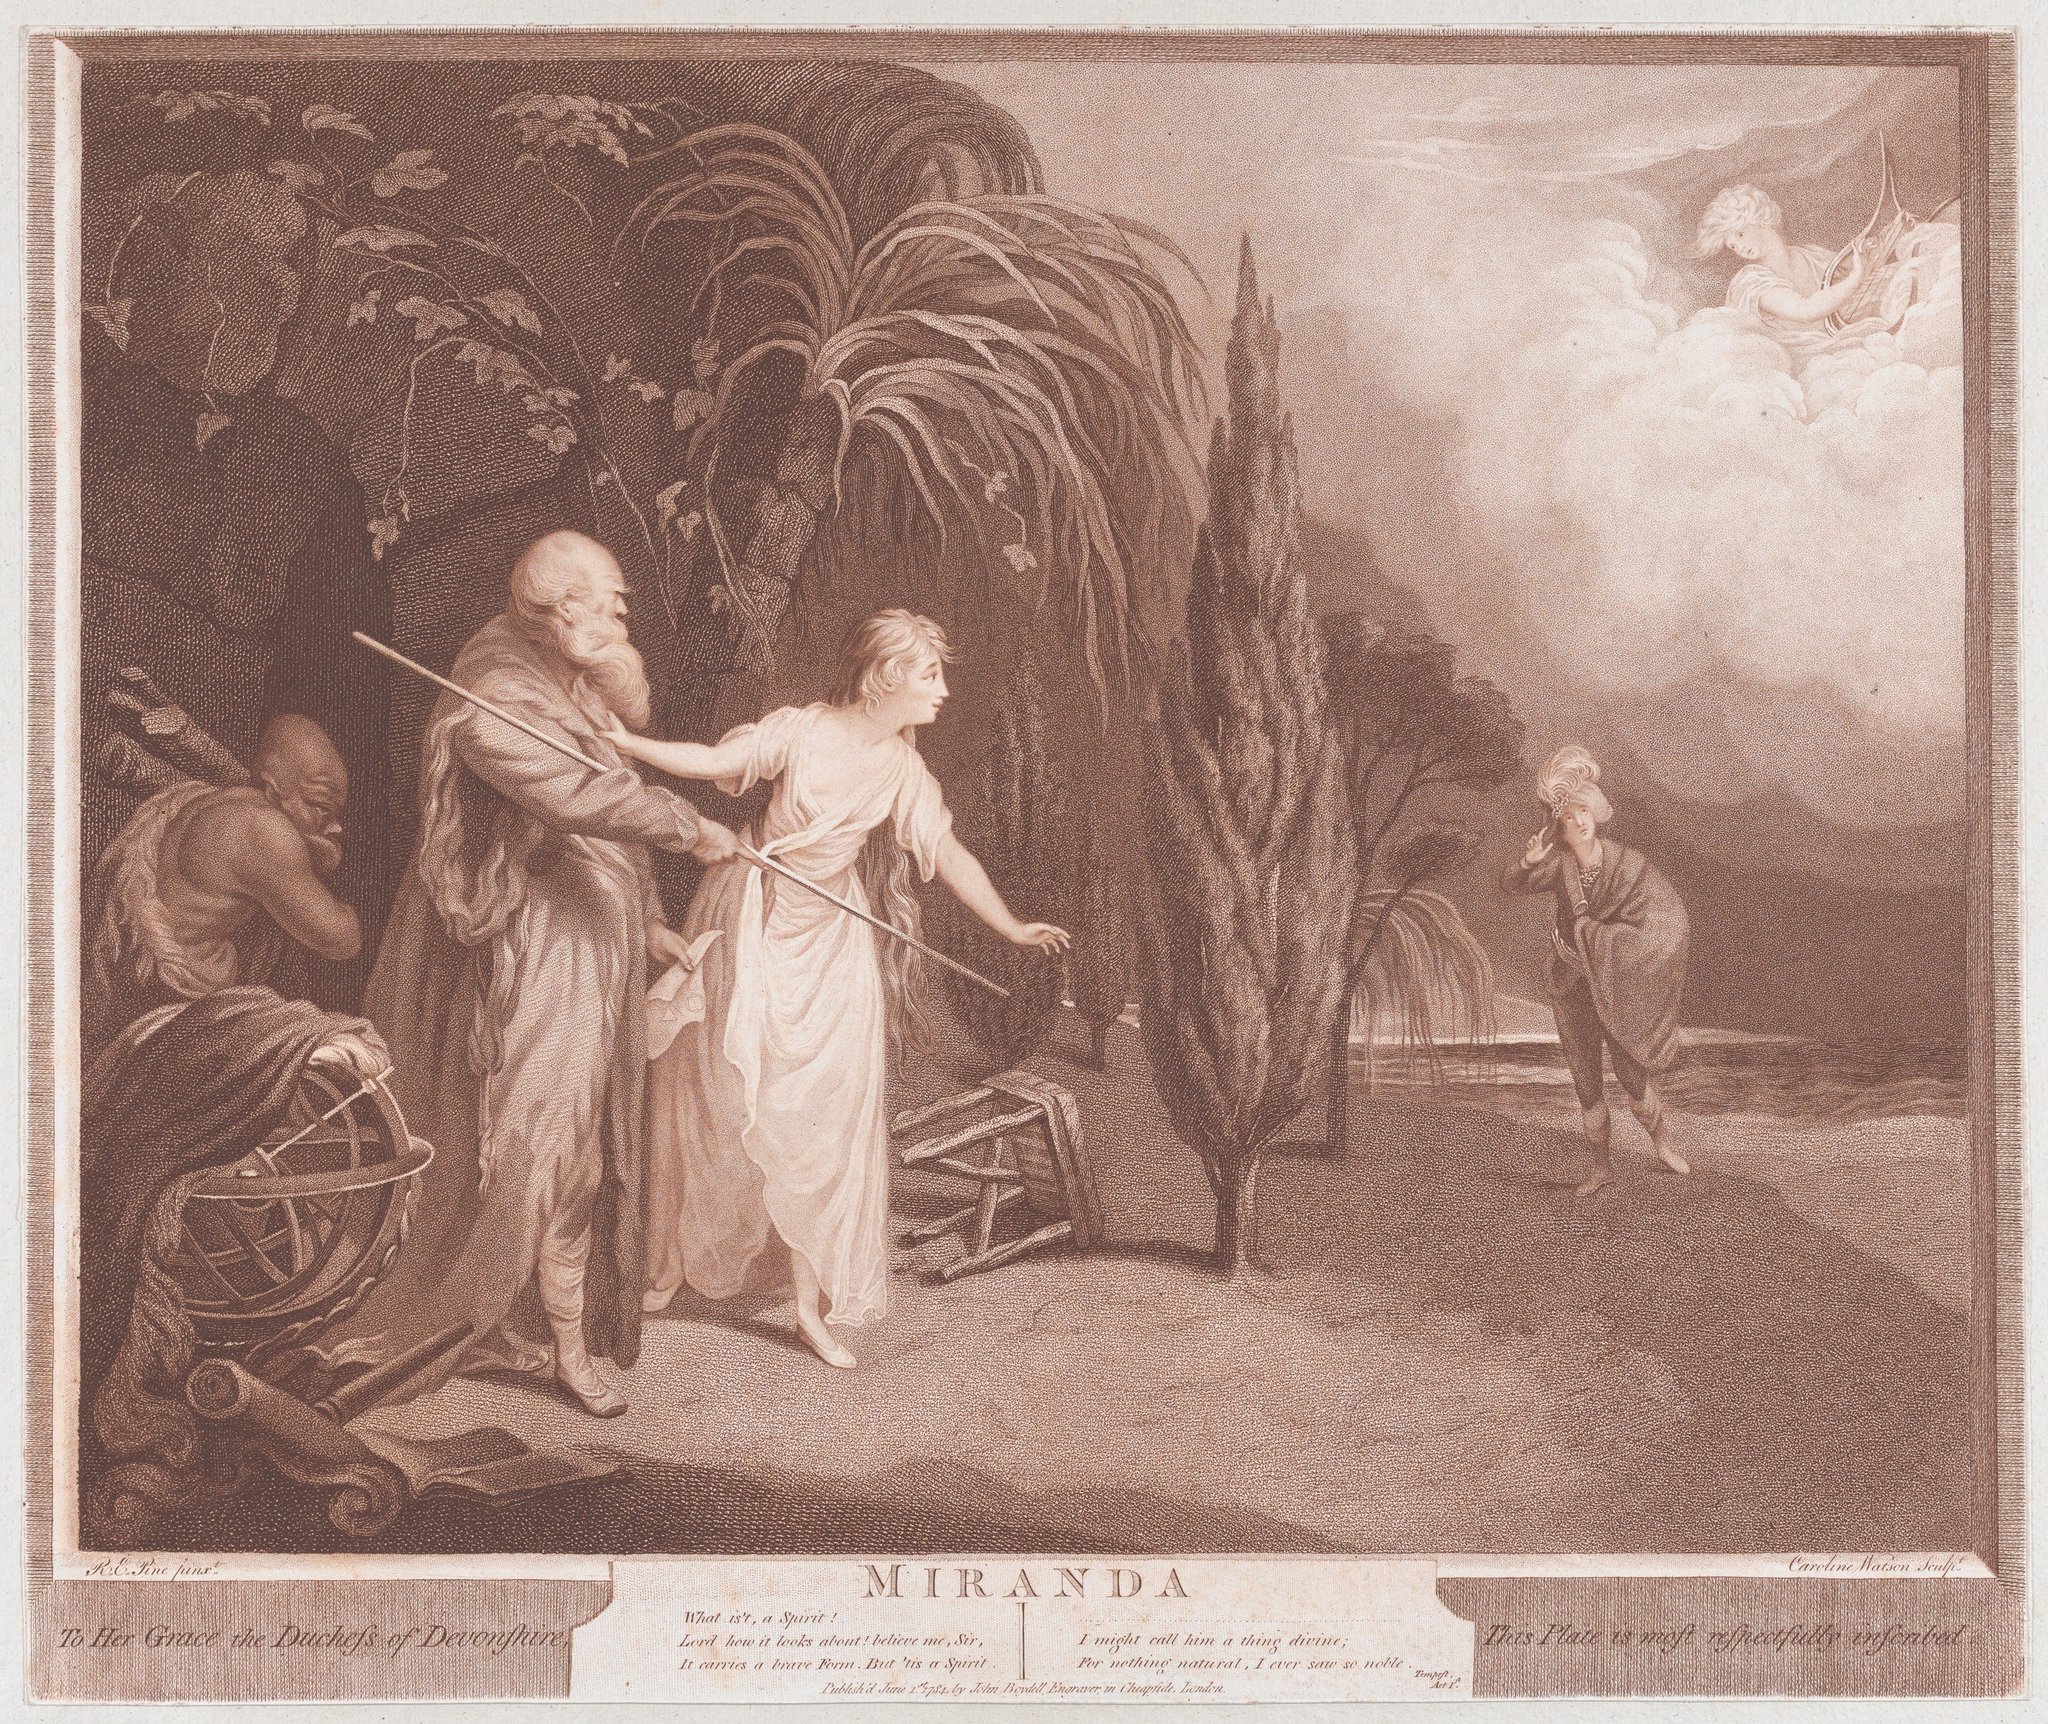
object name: print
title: Miranda (Shakespeare, The Tempest, Act 1, Scene 2)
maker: caroline watson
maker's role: engraver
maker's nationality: british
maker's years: 1760-1814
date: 1784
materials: ink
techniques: printing, engraving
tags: shakespeare,men,women